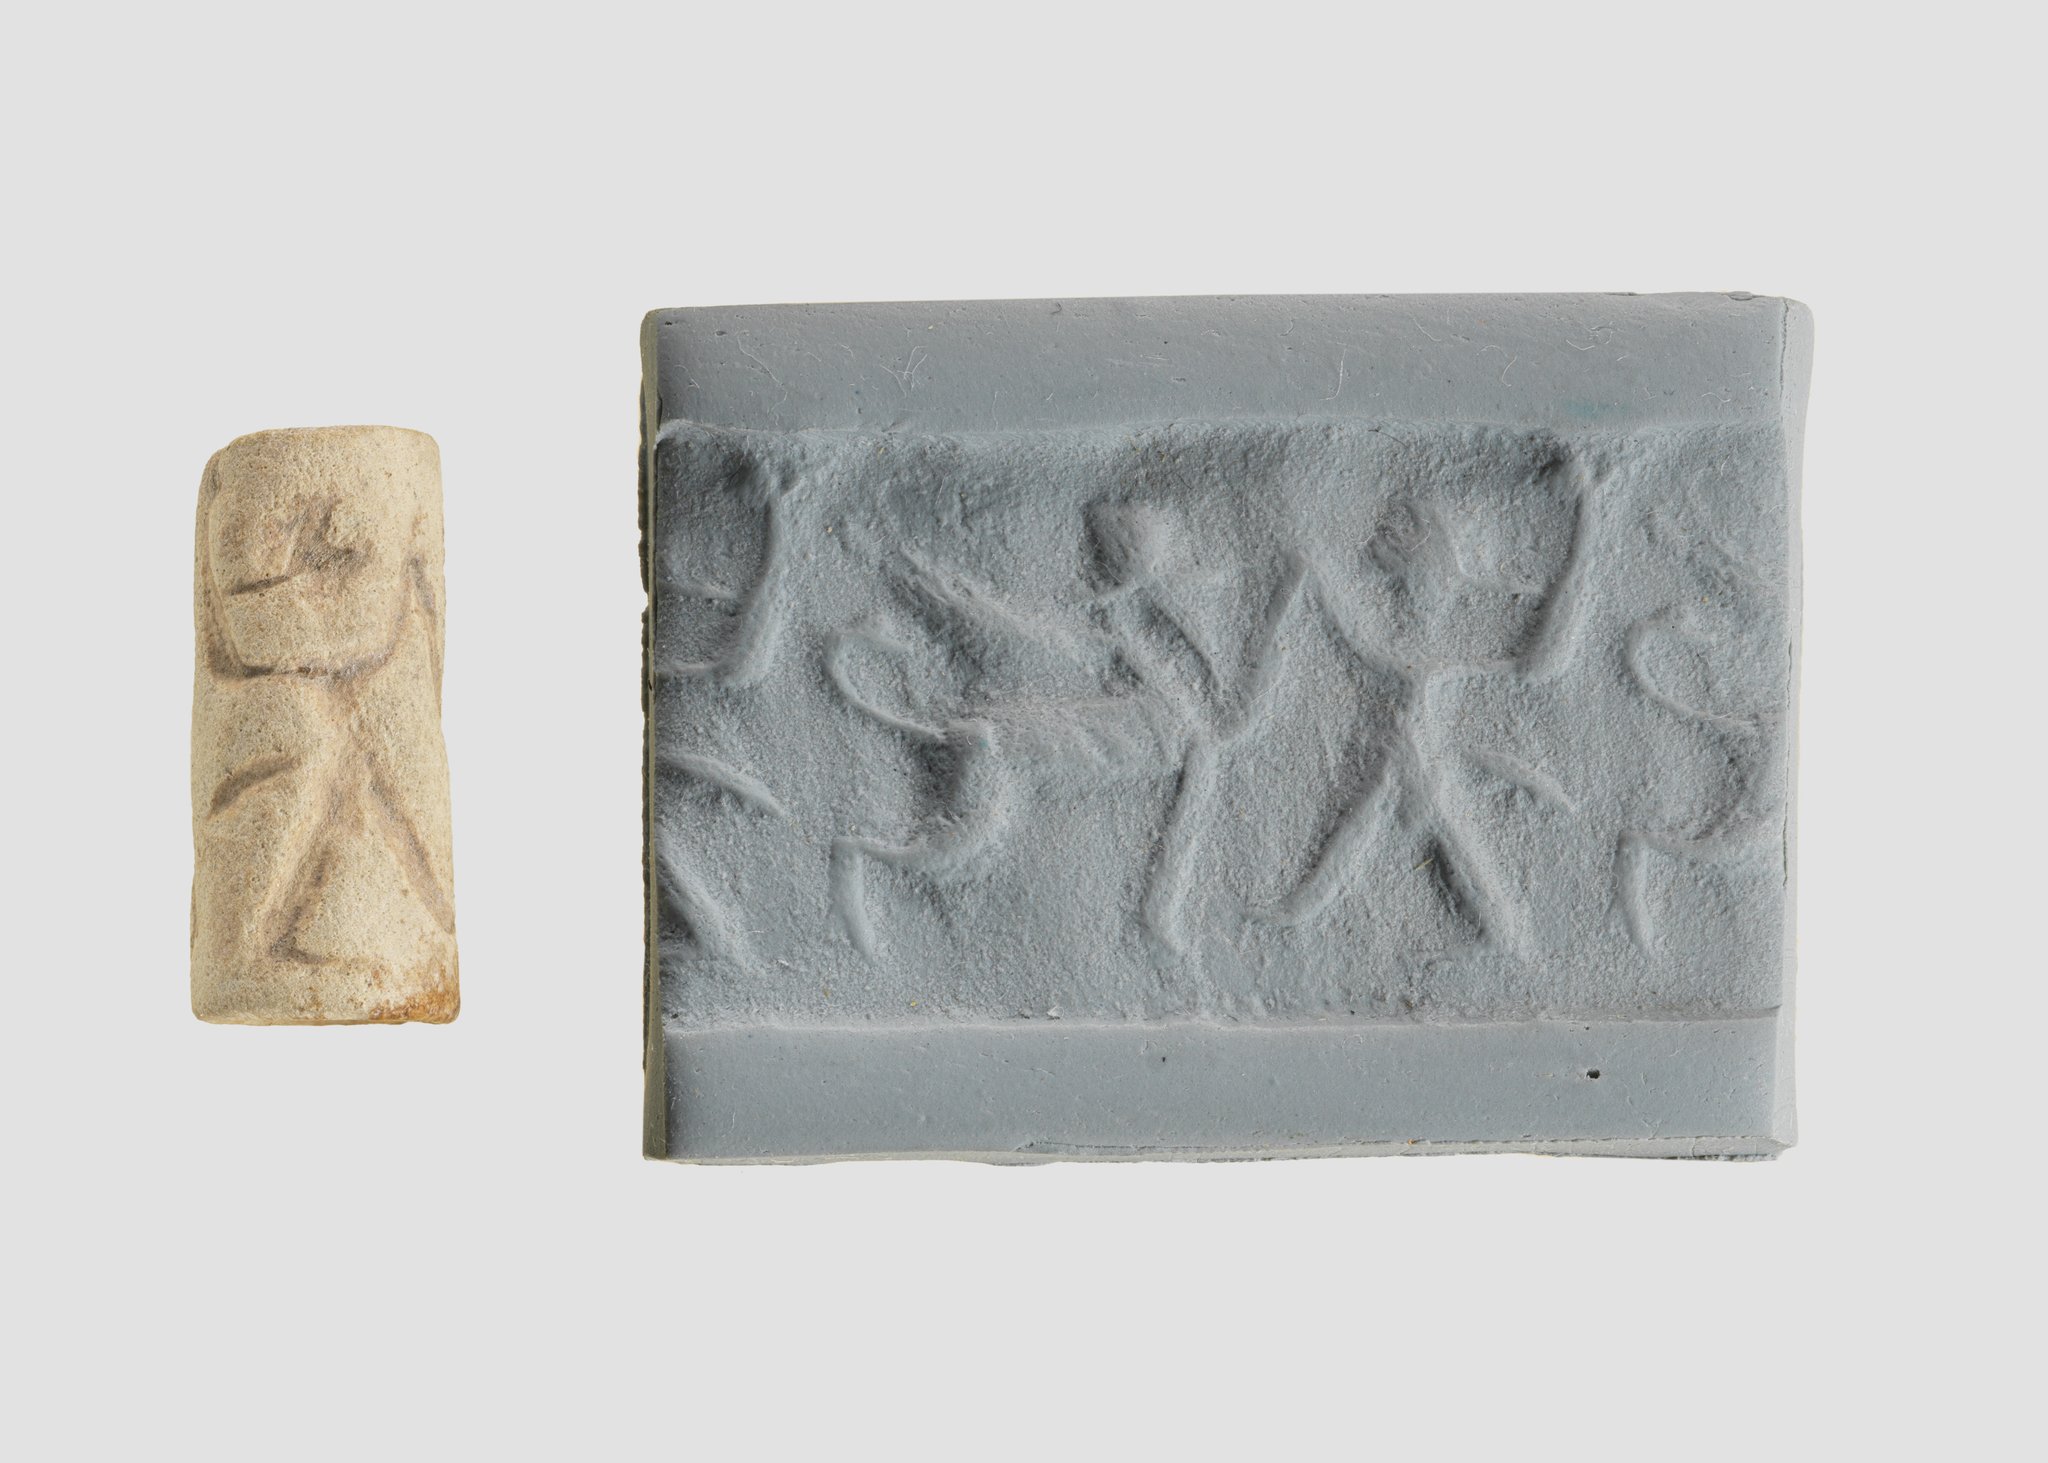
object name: cylinder seal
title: Cylinder seal with two-figure contest scene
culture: assyro-babylonian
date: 734-601 BCE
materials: faience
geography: mesopotamia or iran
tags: animals